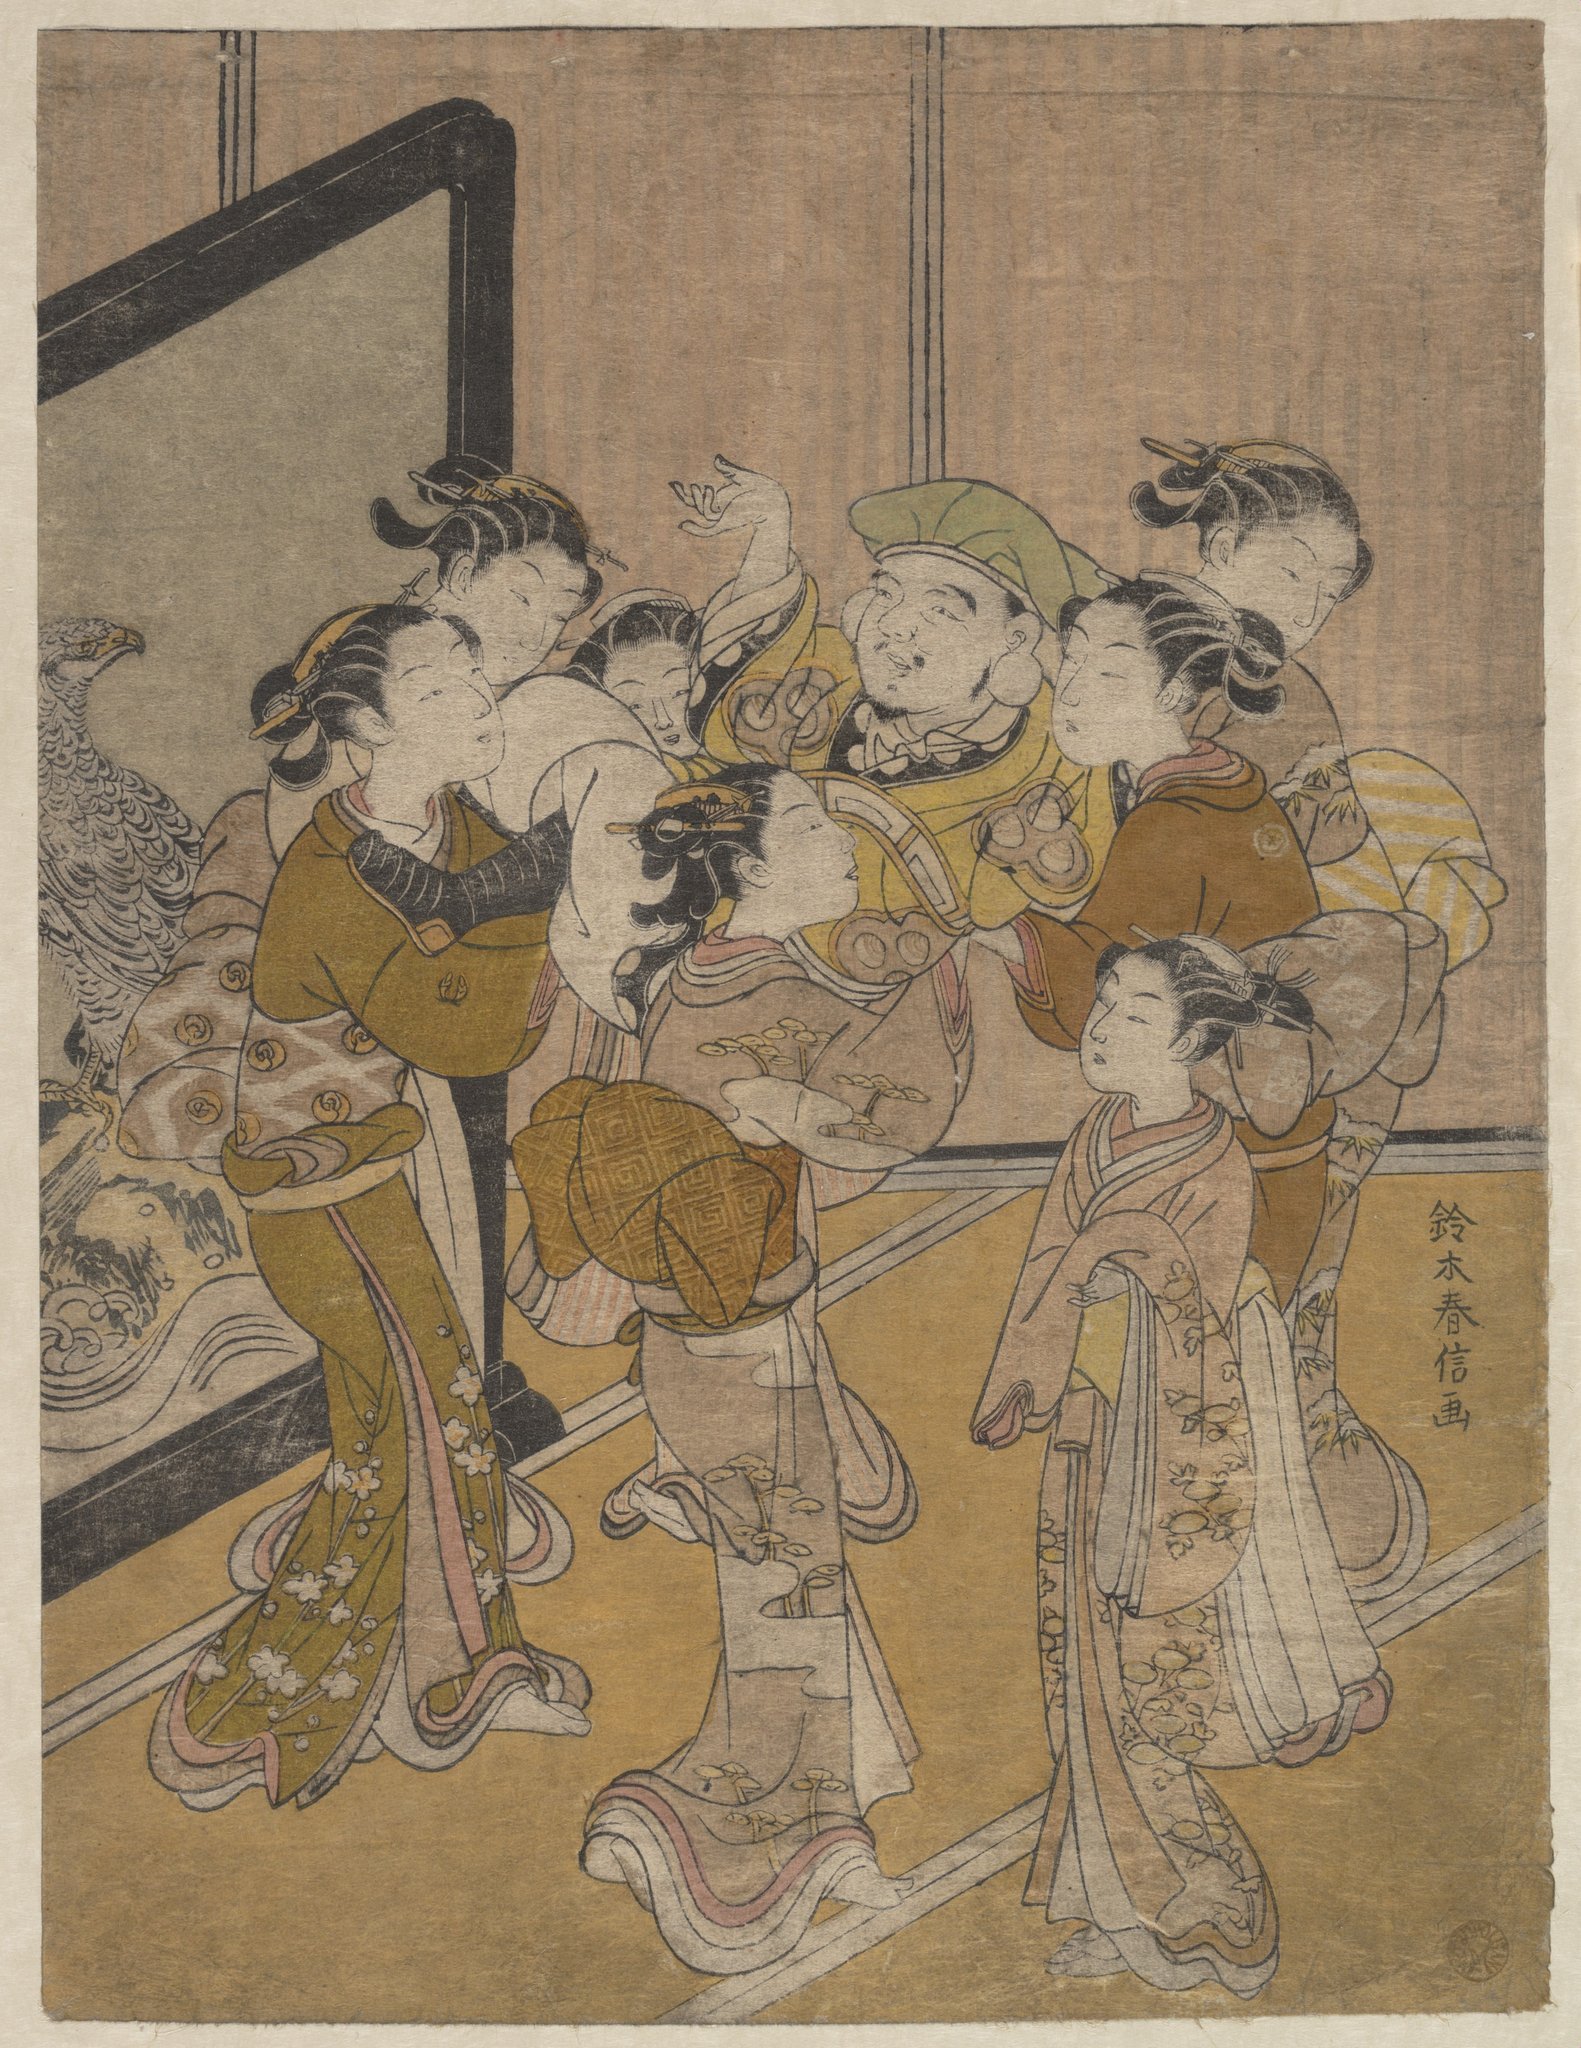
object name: print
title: Daikoku Dōagé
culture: japanese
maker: suzuki harunobu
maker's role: artist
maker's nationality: japanese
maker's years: 1725-1770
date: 1766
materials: ink, paper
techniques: woodblock print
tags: men,women